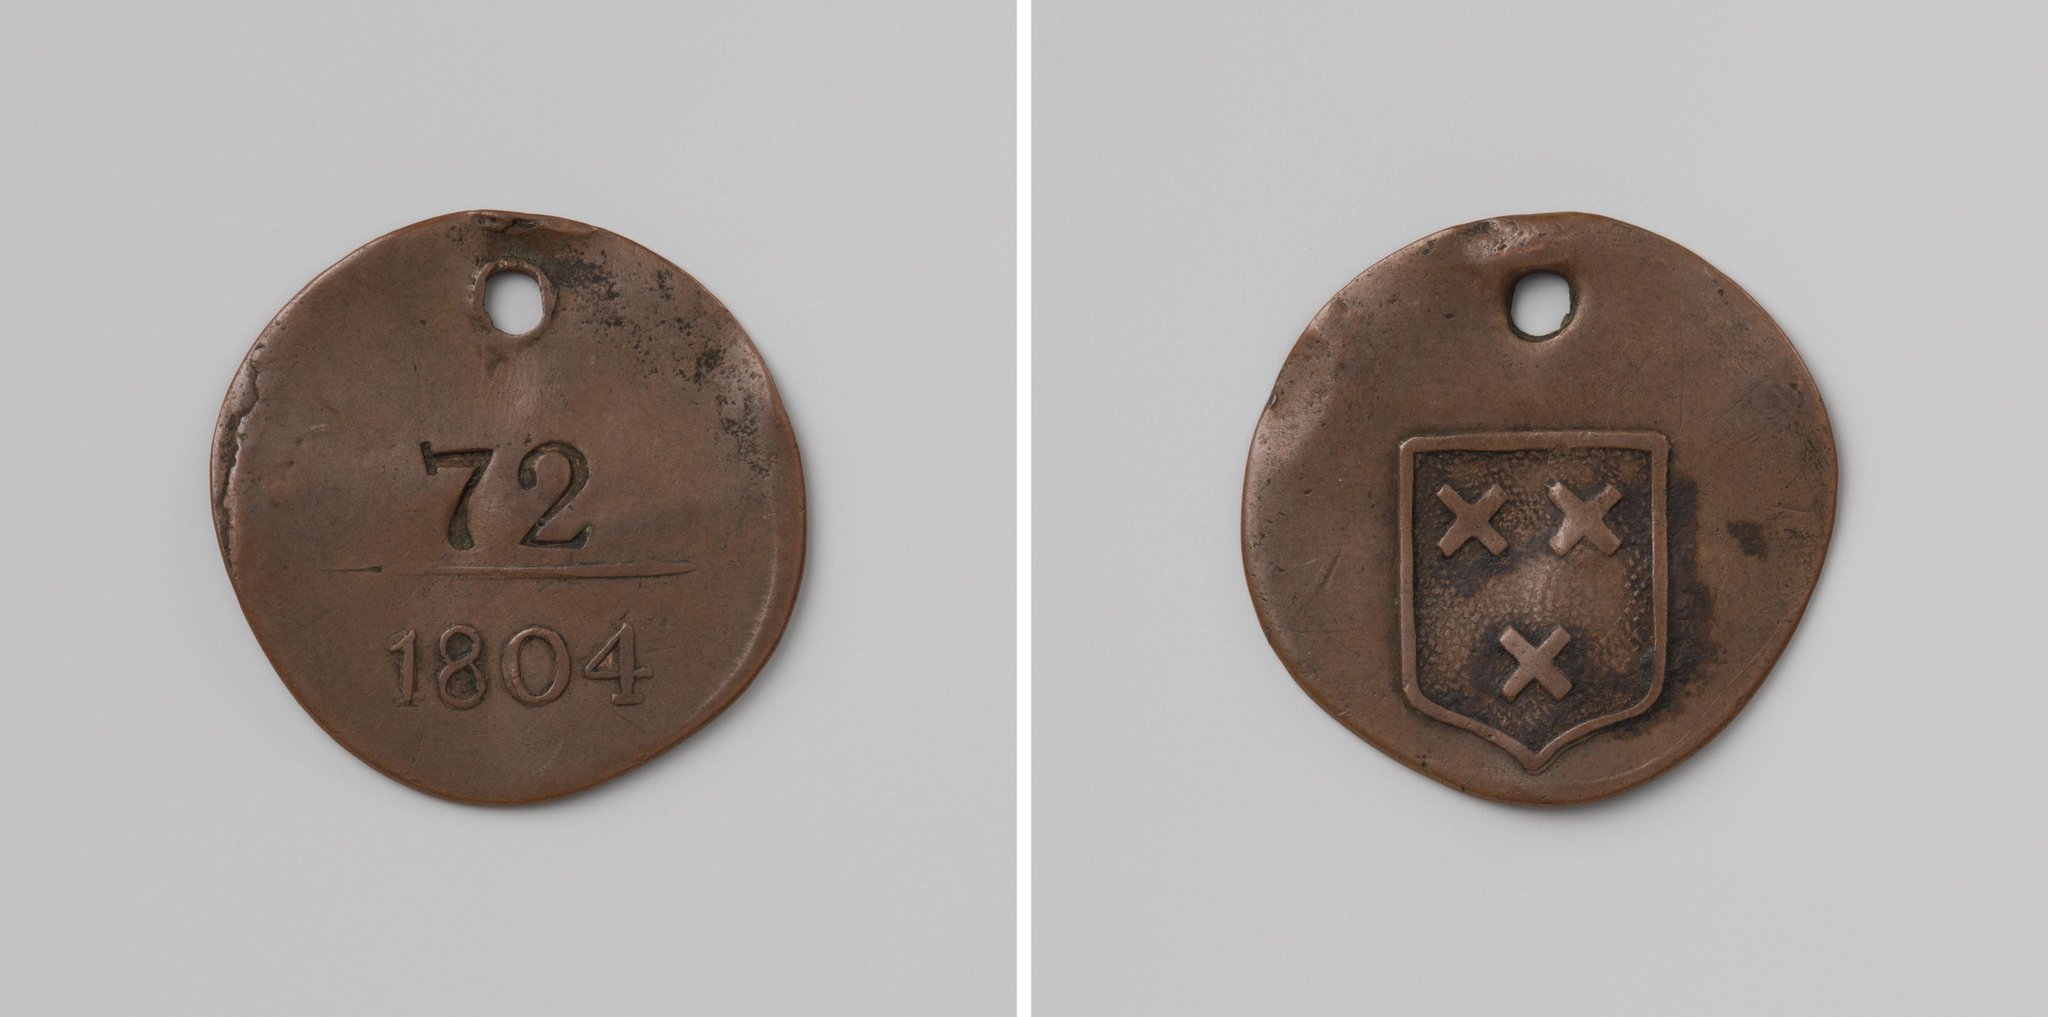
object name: tax token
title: Stad Breda, loodje met no. 72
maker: Anonymous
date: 1804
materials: copper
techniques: striking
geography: breda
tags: breda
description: loodje met gat erin. Voorzijde: cijfer 72 boven jaartal. Keerzijde: wapenschild